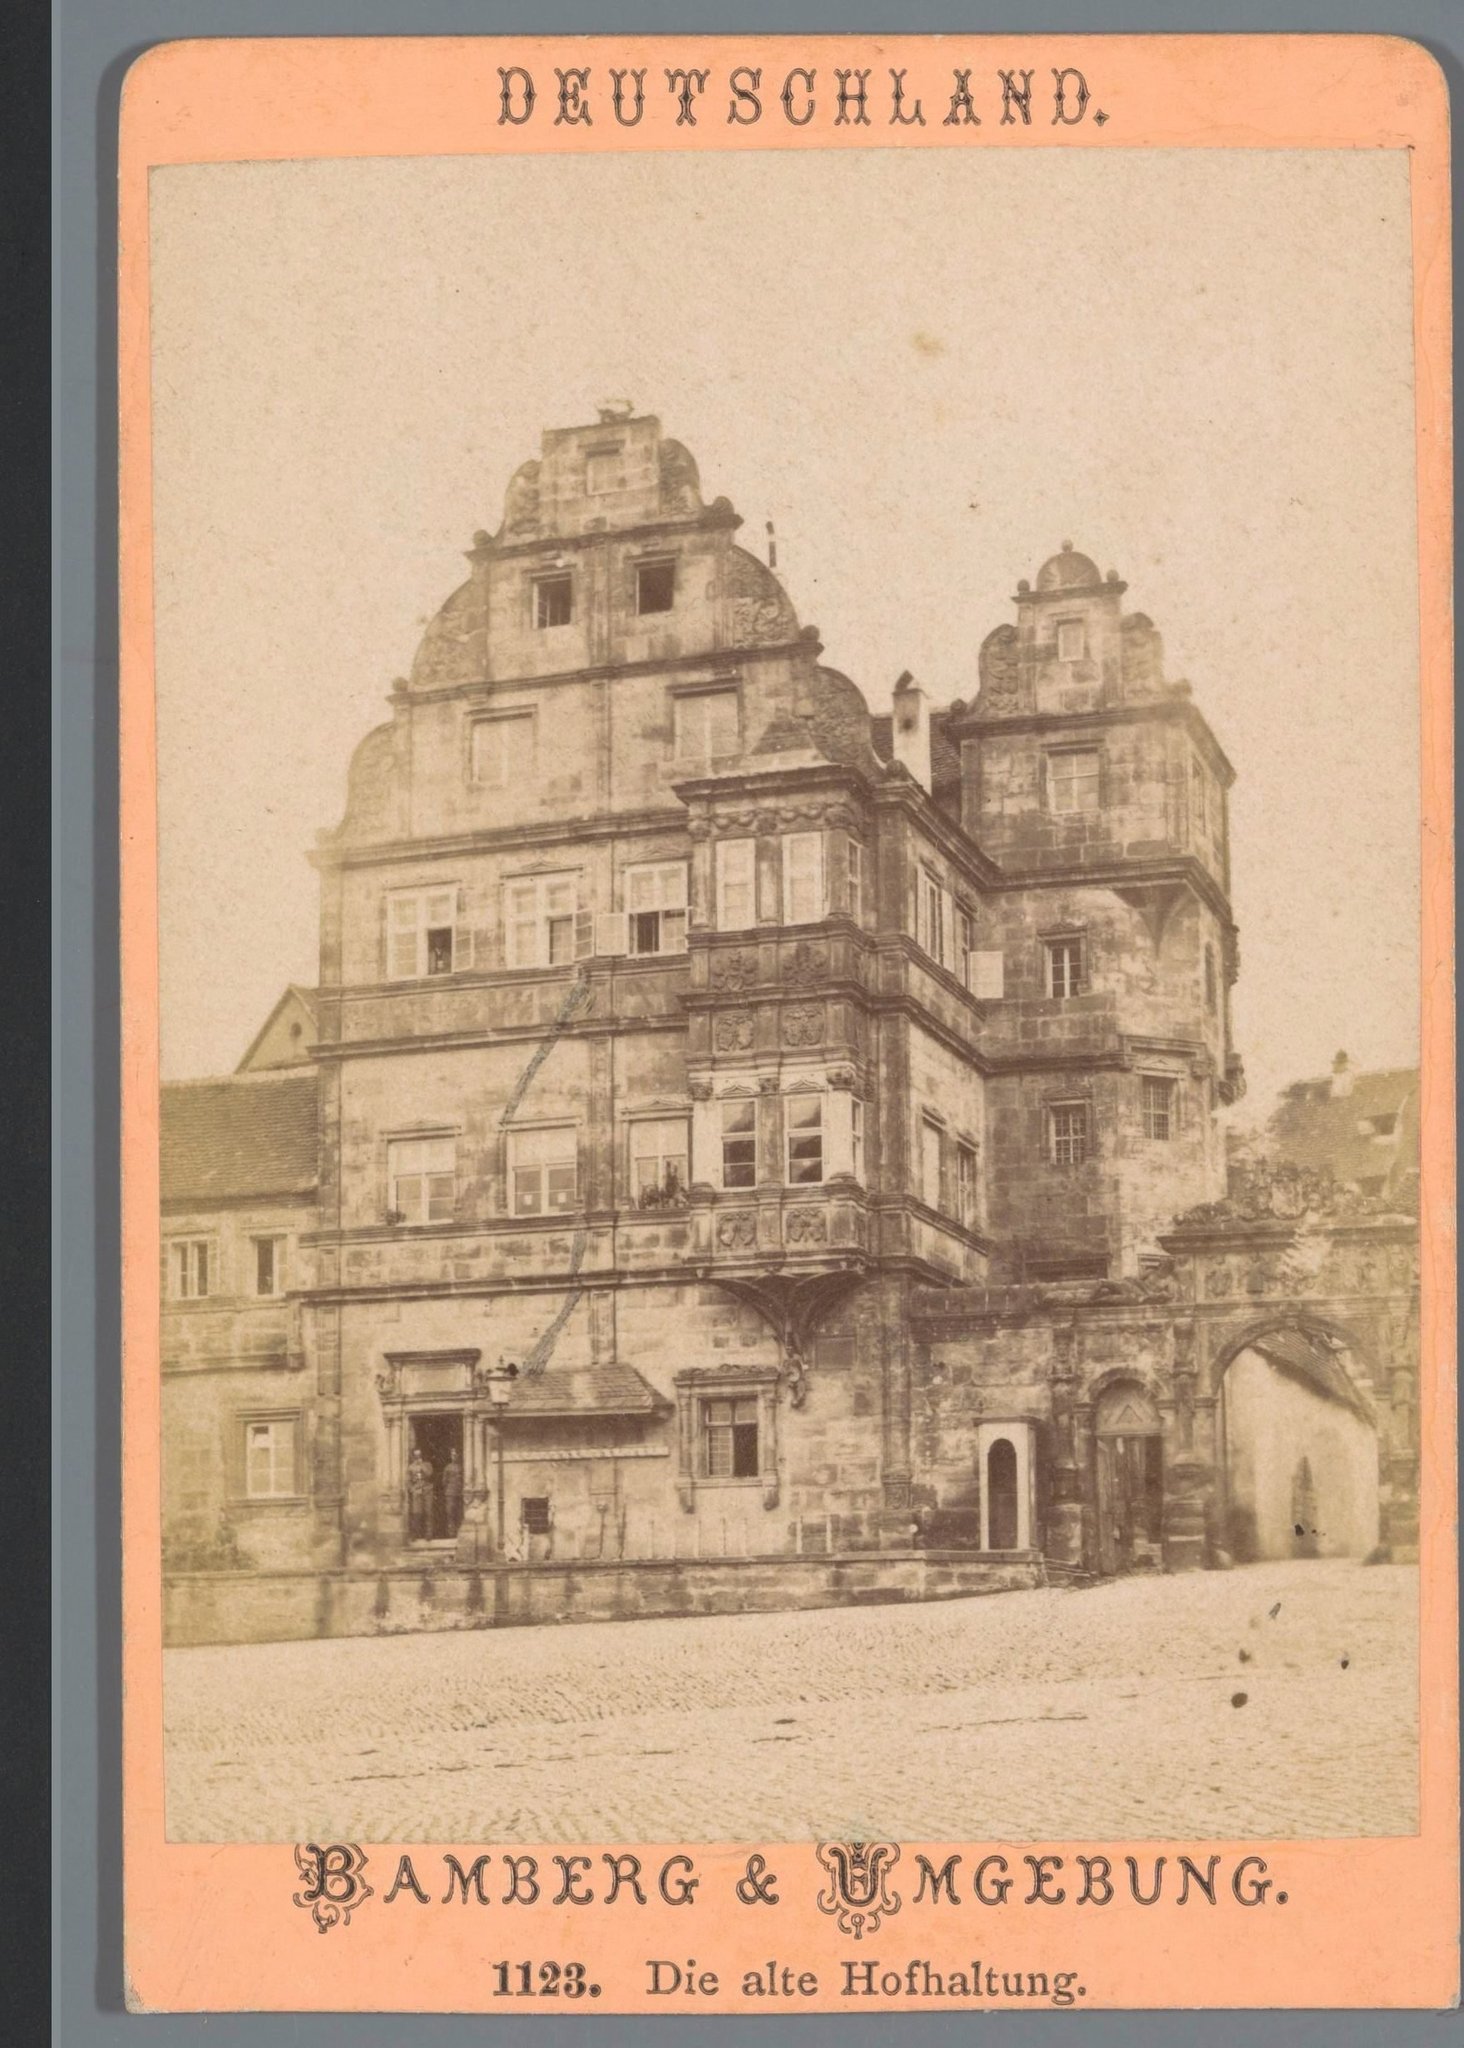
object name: photograph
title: Bamberg und Umgebung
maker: s.p. christmann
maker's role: publisher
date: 1860-1890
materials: cardboard, paper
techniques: albumen print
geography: berlin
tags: exterior ~ representation of a building, façade (of house or building)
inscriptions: number: ‘1123.’